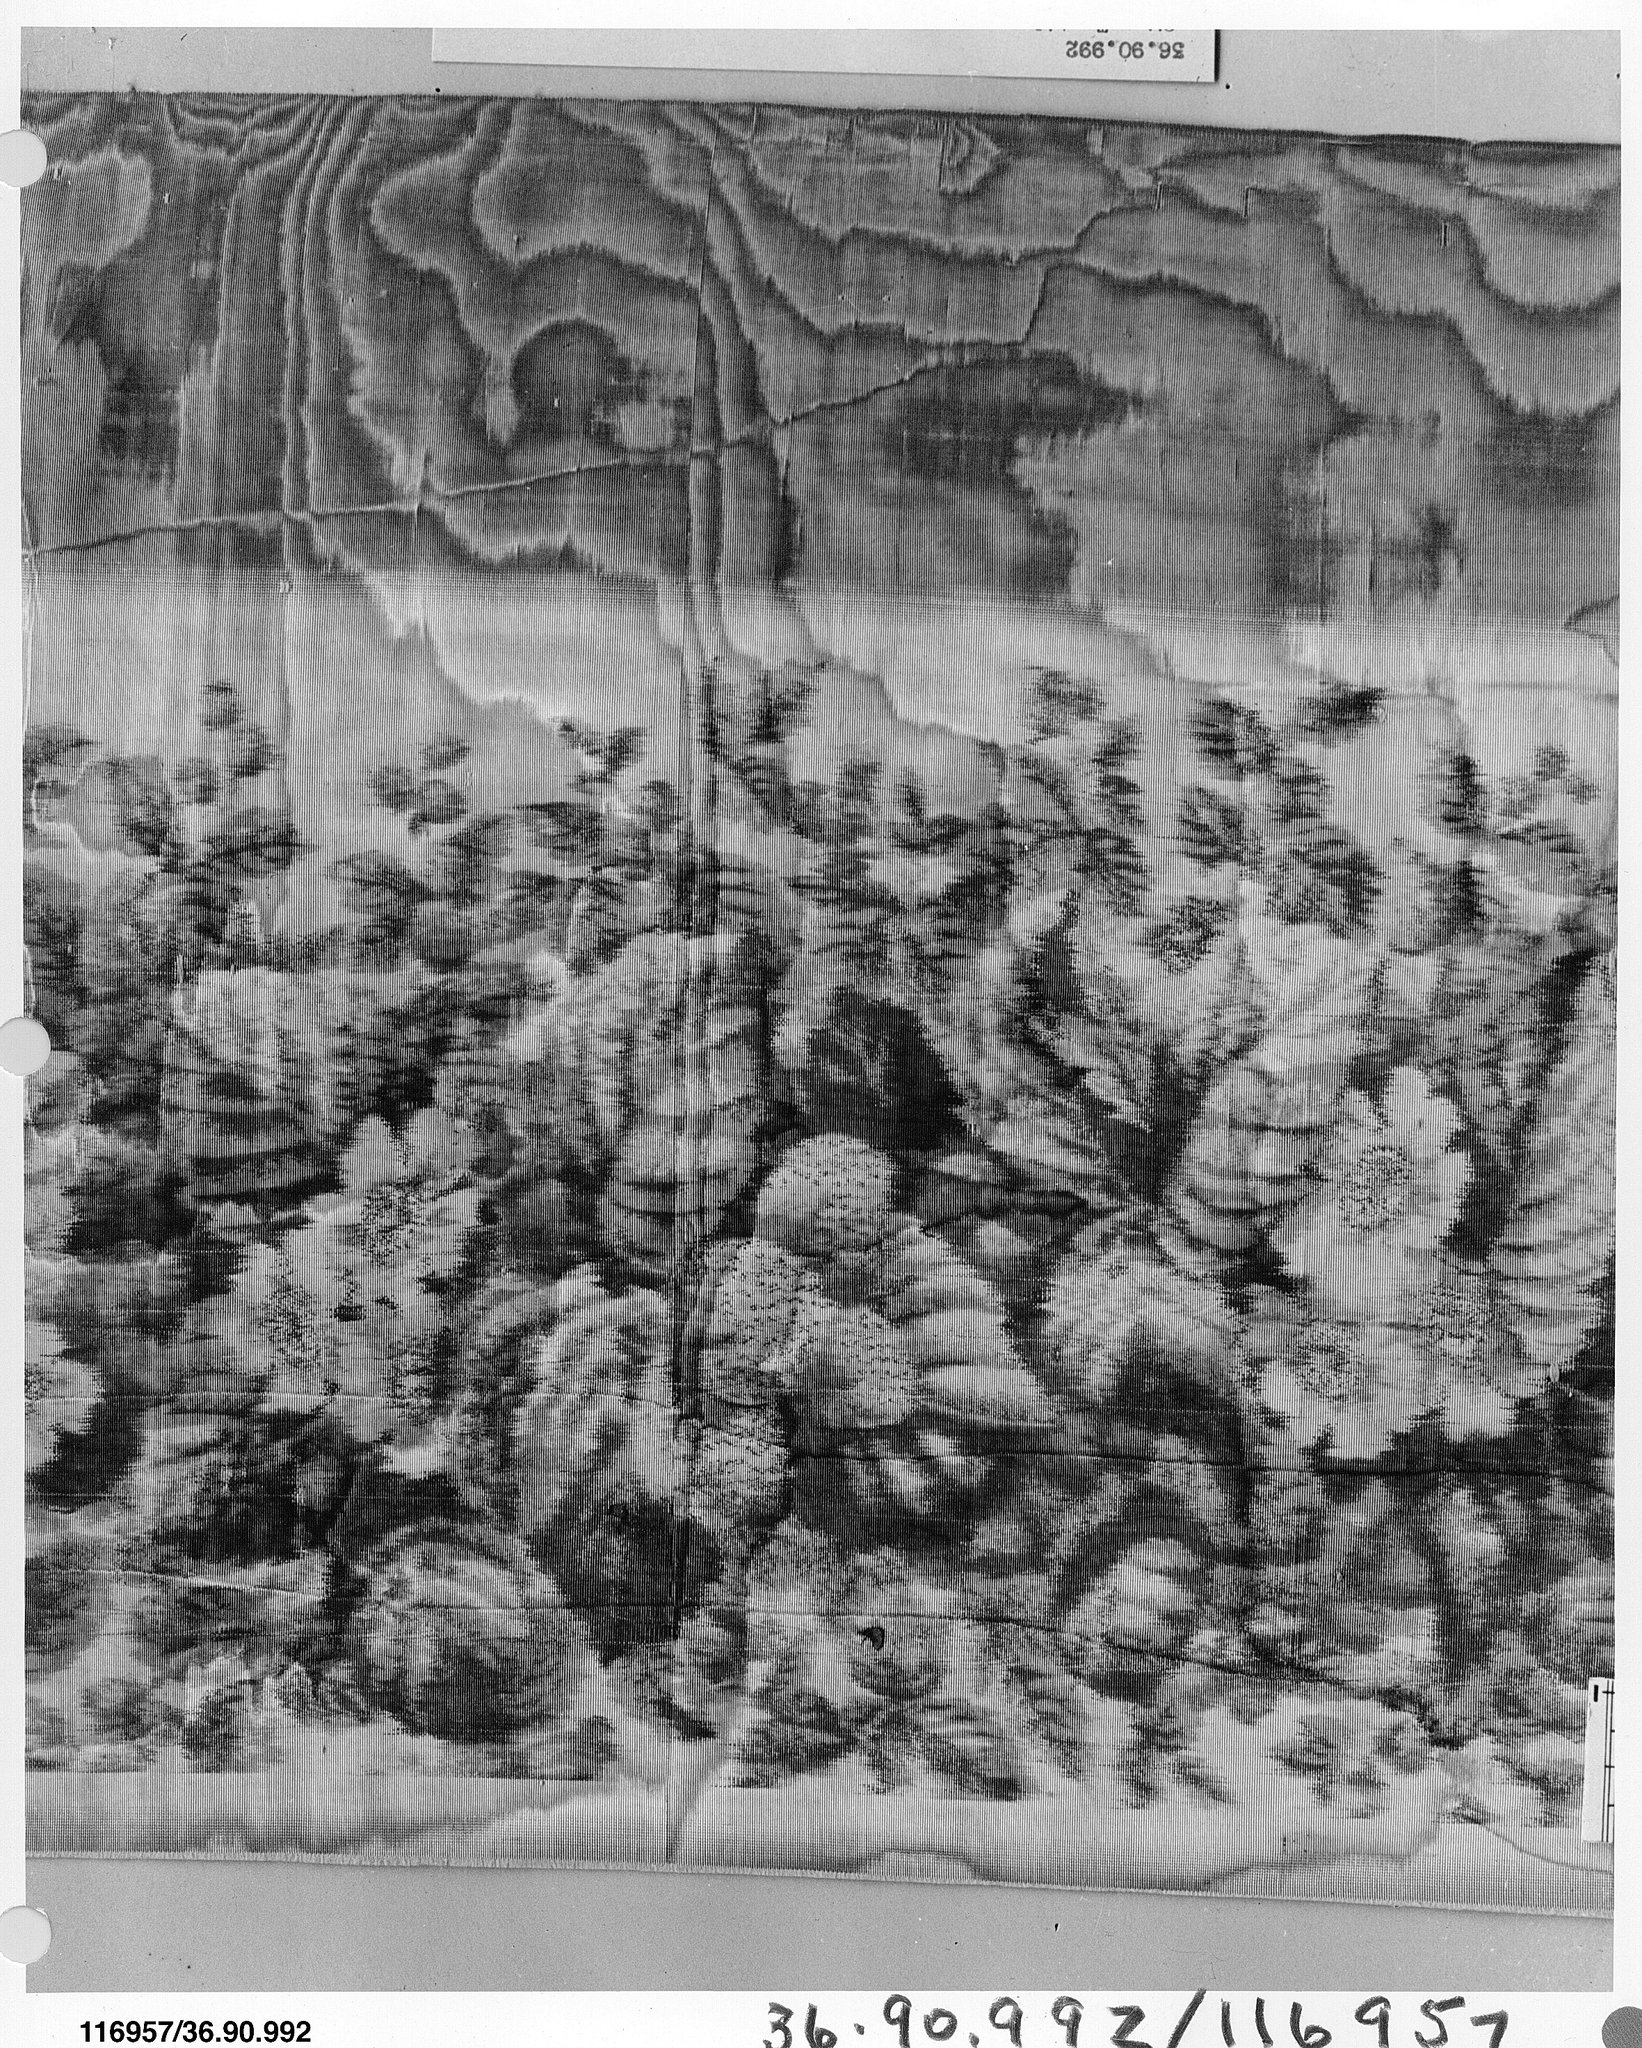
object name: piece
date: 1867-1900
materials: silk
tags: flowers,leaves